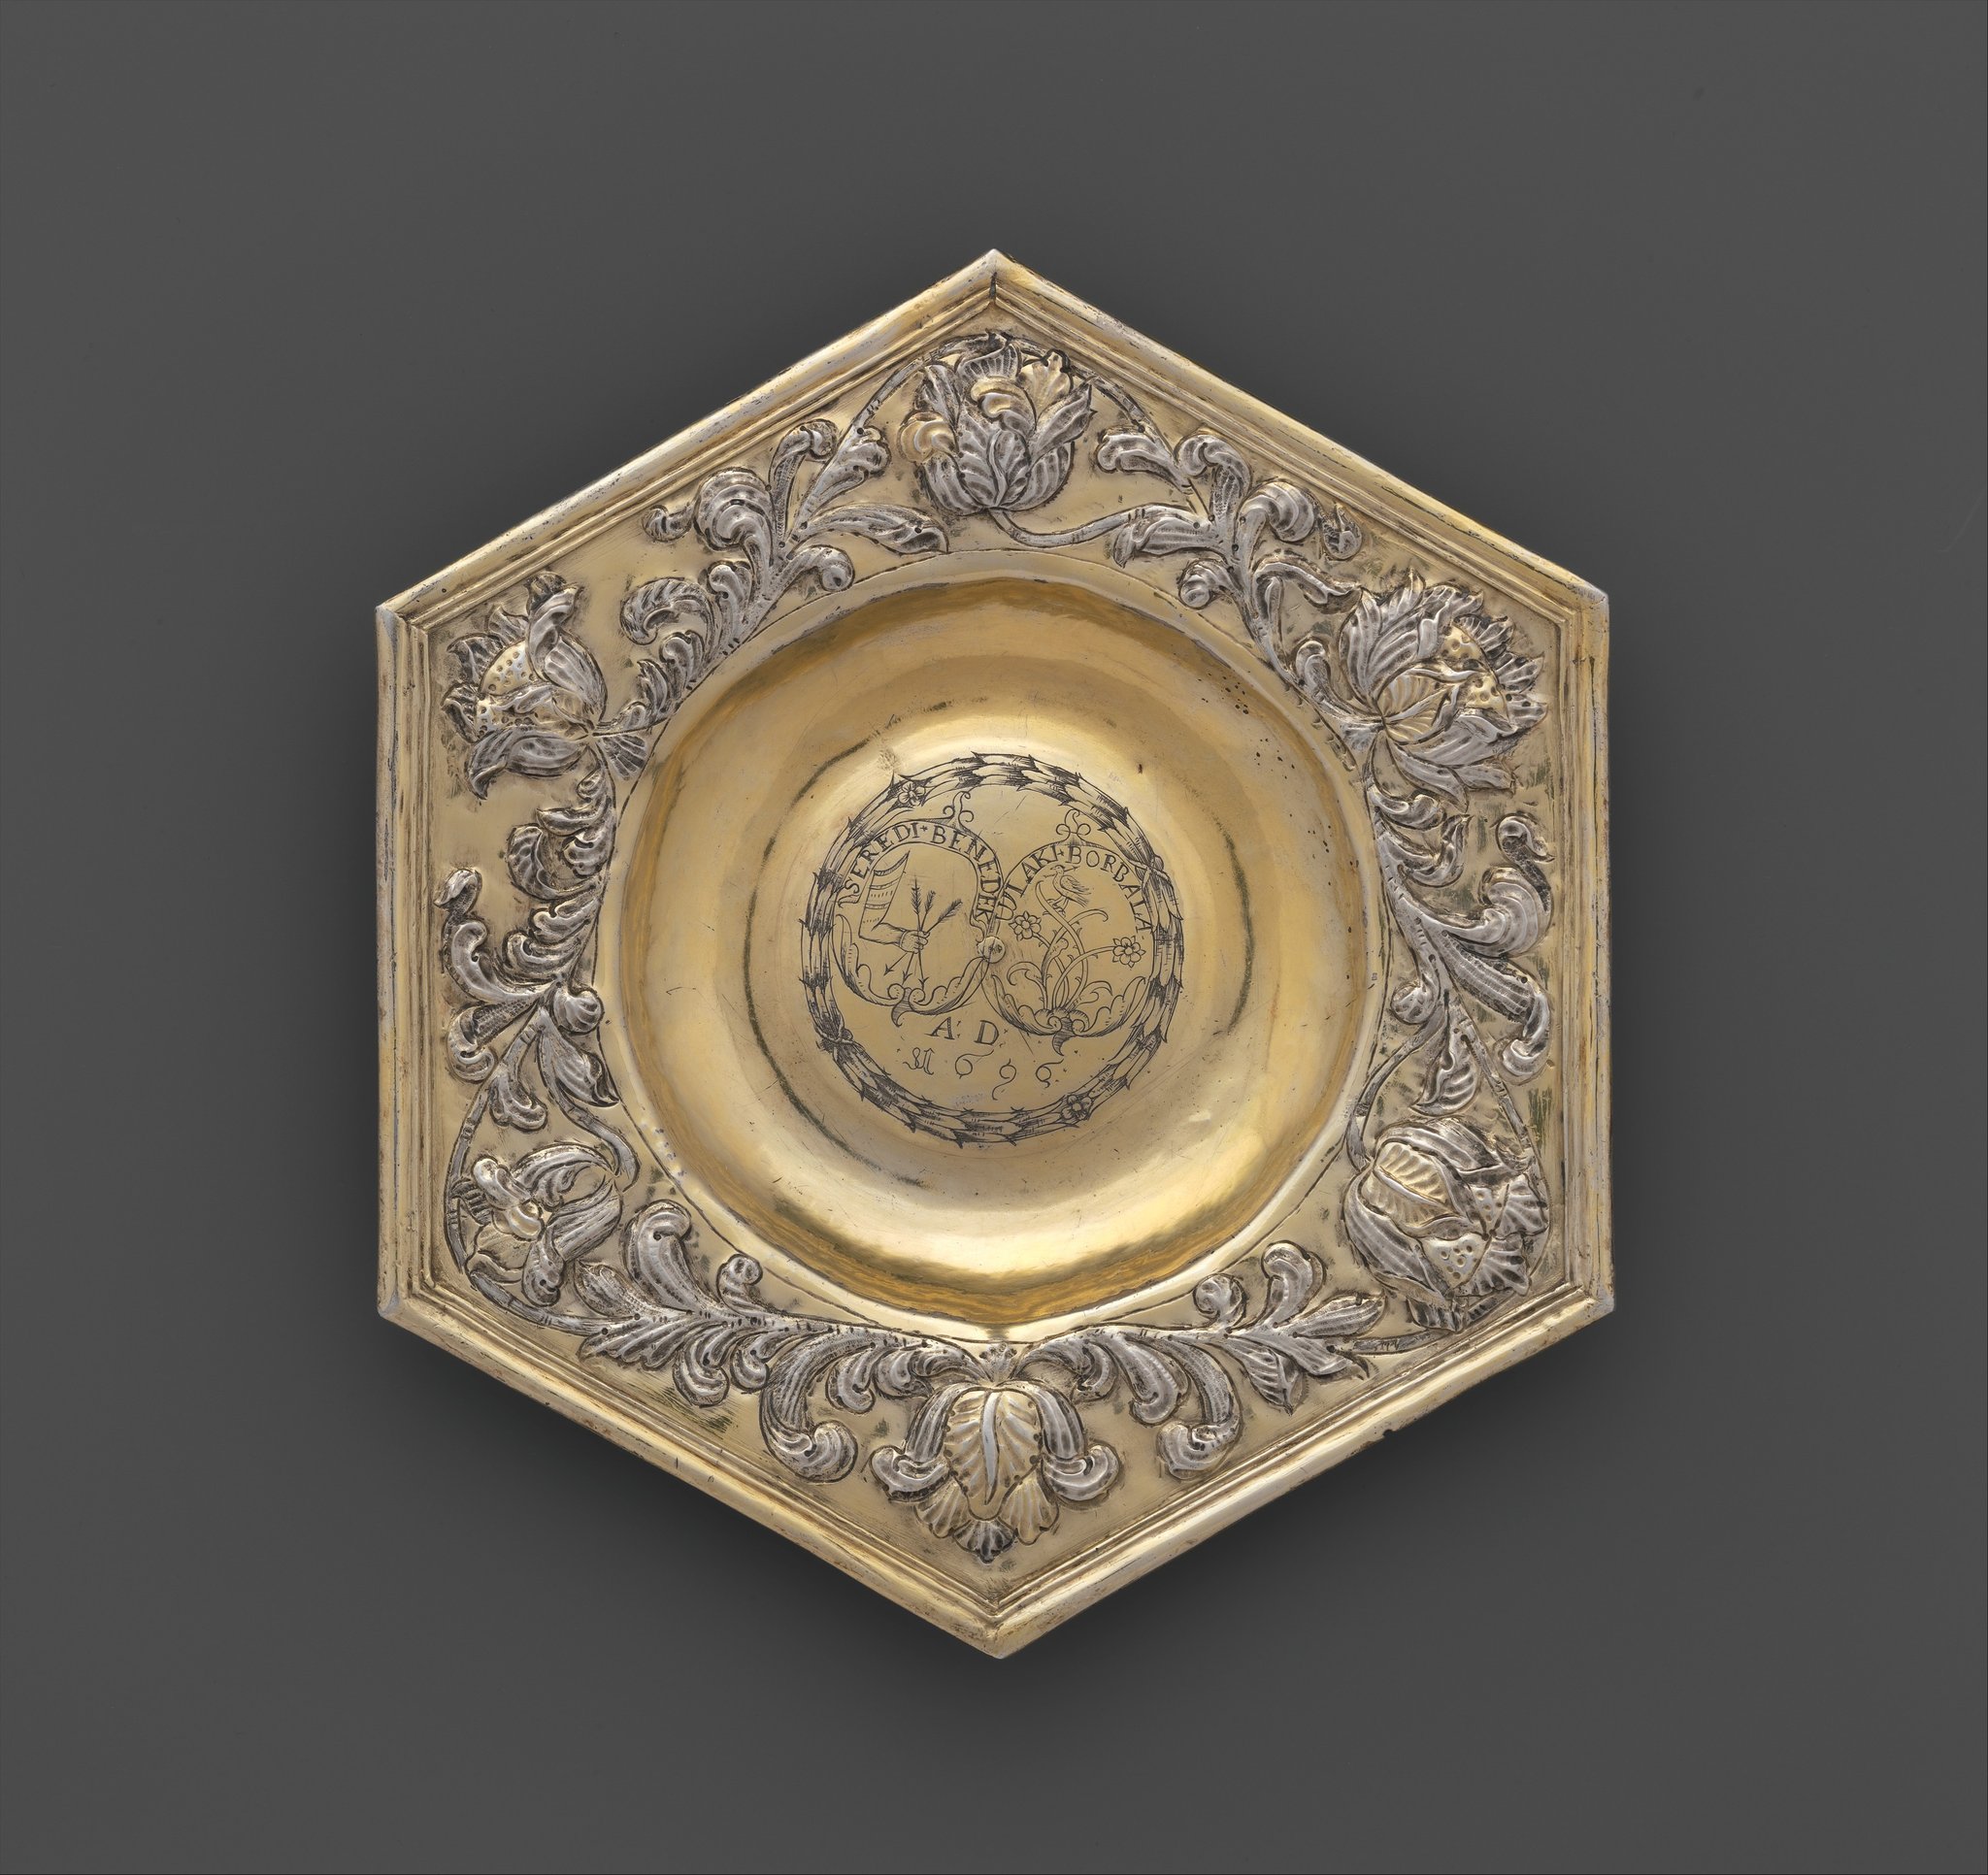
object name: dish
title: Hexagonal dish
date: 1696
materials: silver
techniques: gilding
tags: flowers,coat of arms